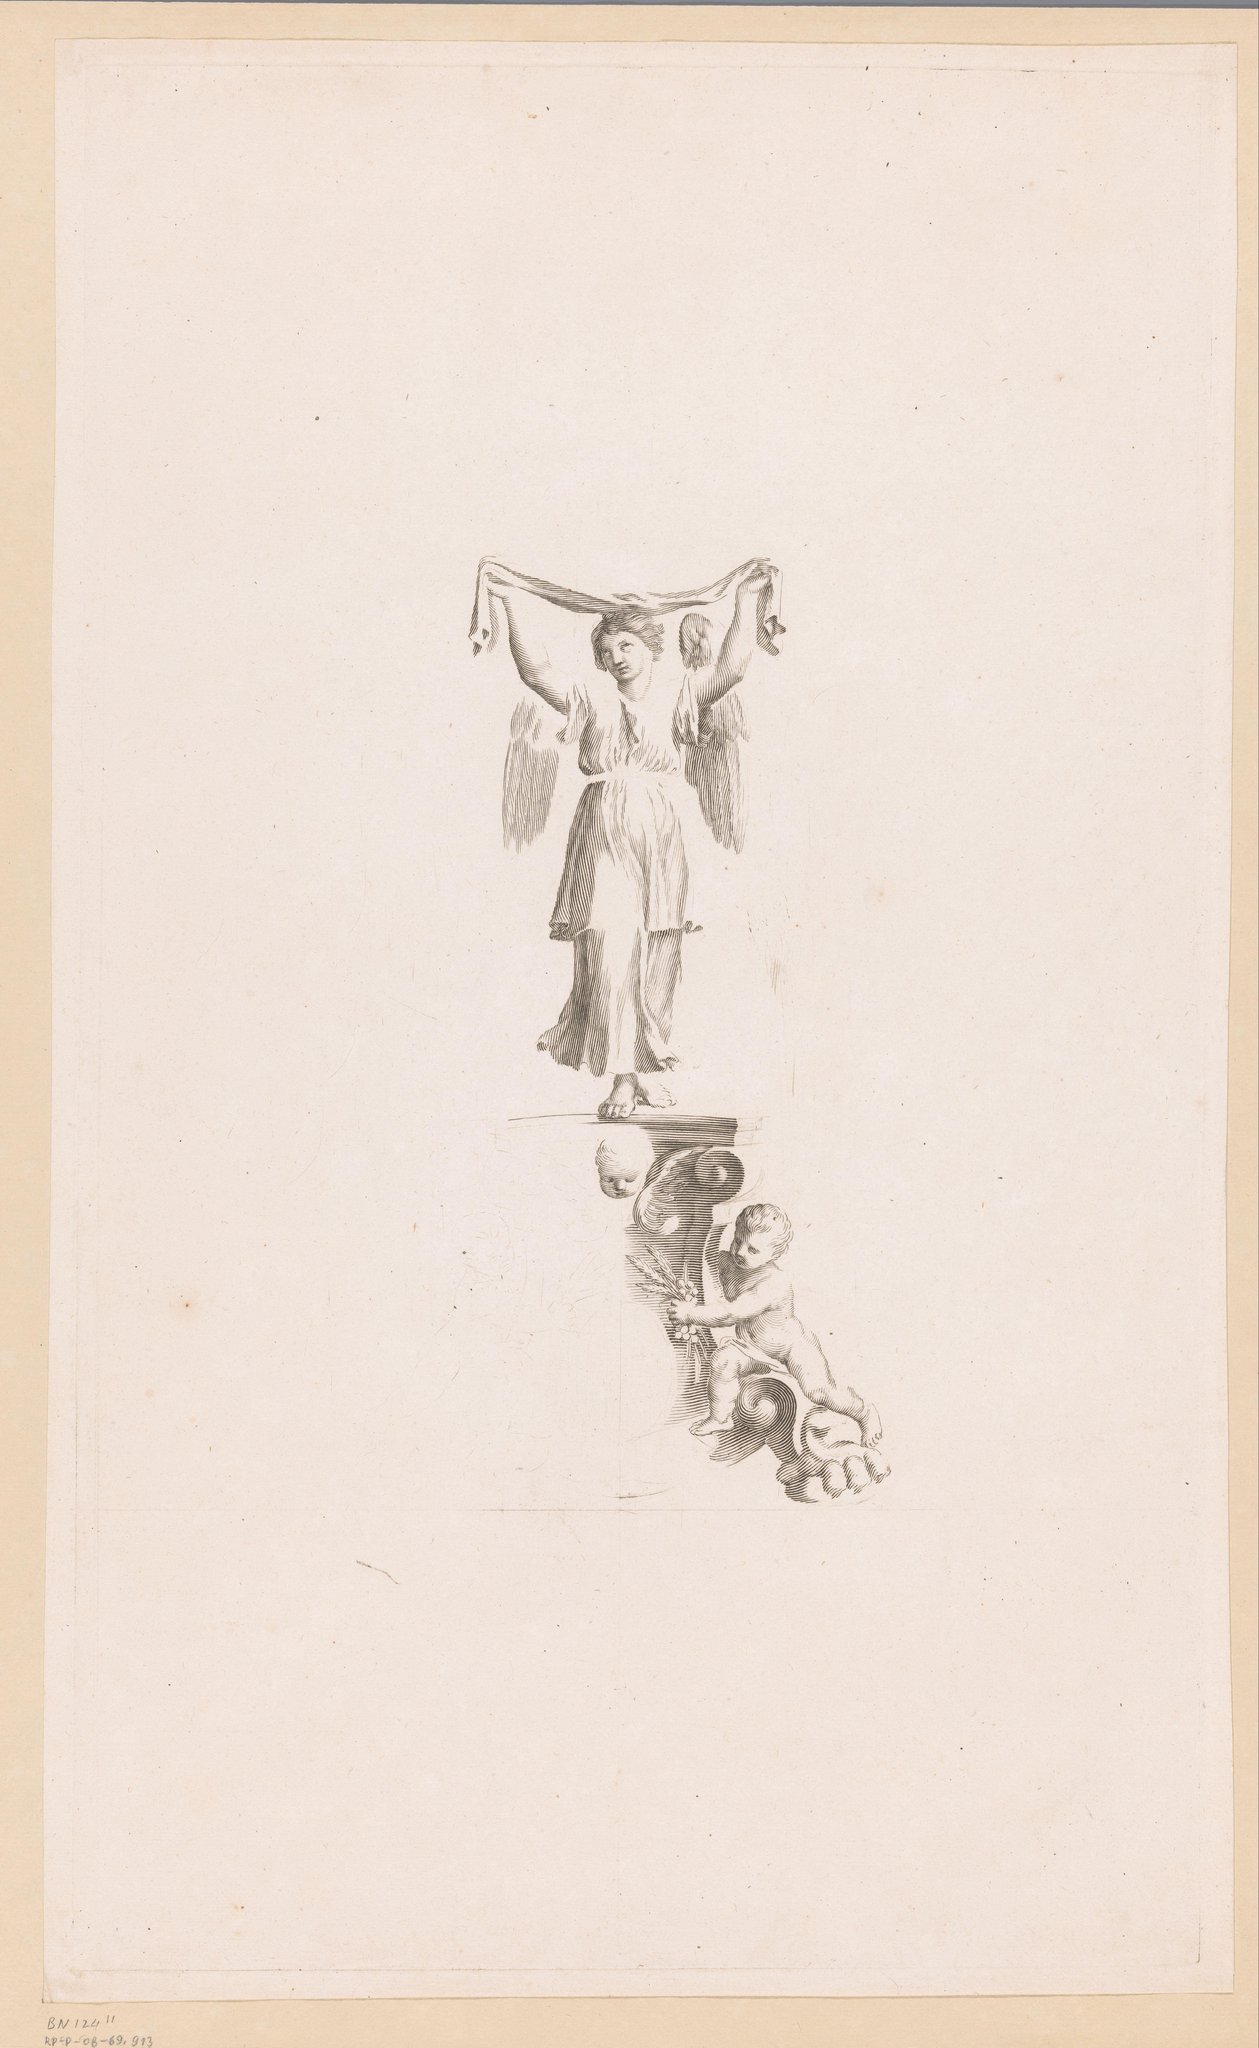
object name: print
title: Engel met opgeheven doek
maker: claude mellan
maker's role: draughtsman, print maker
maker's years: 1598-1688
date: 1608-1688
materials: paper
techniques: engraving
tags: angels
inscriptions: collector's mark: Lugt 240